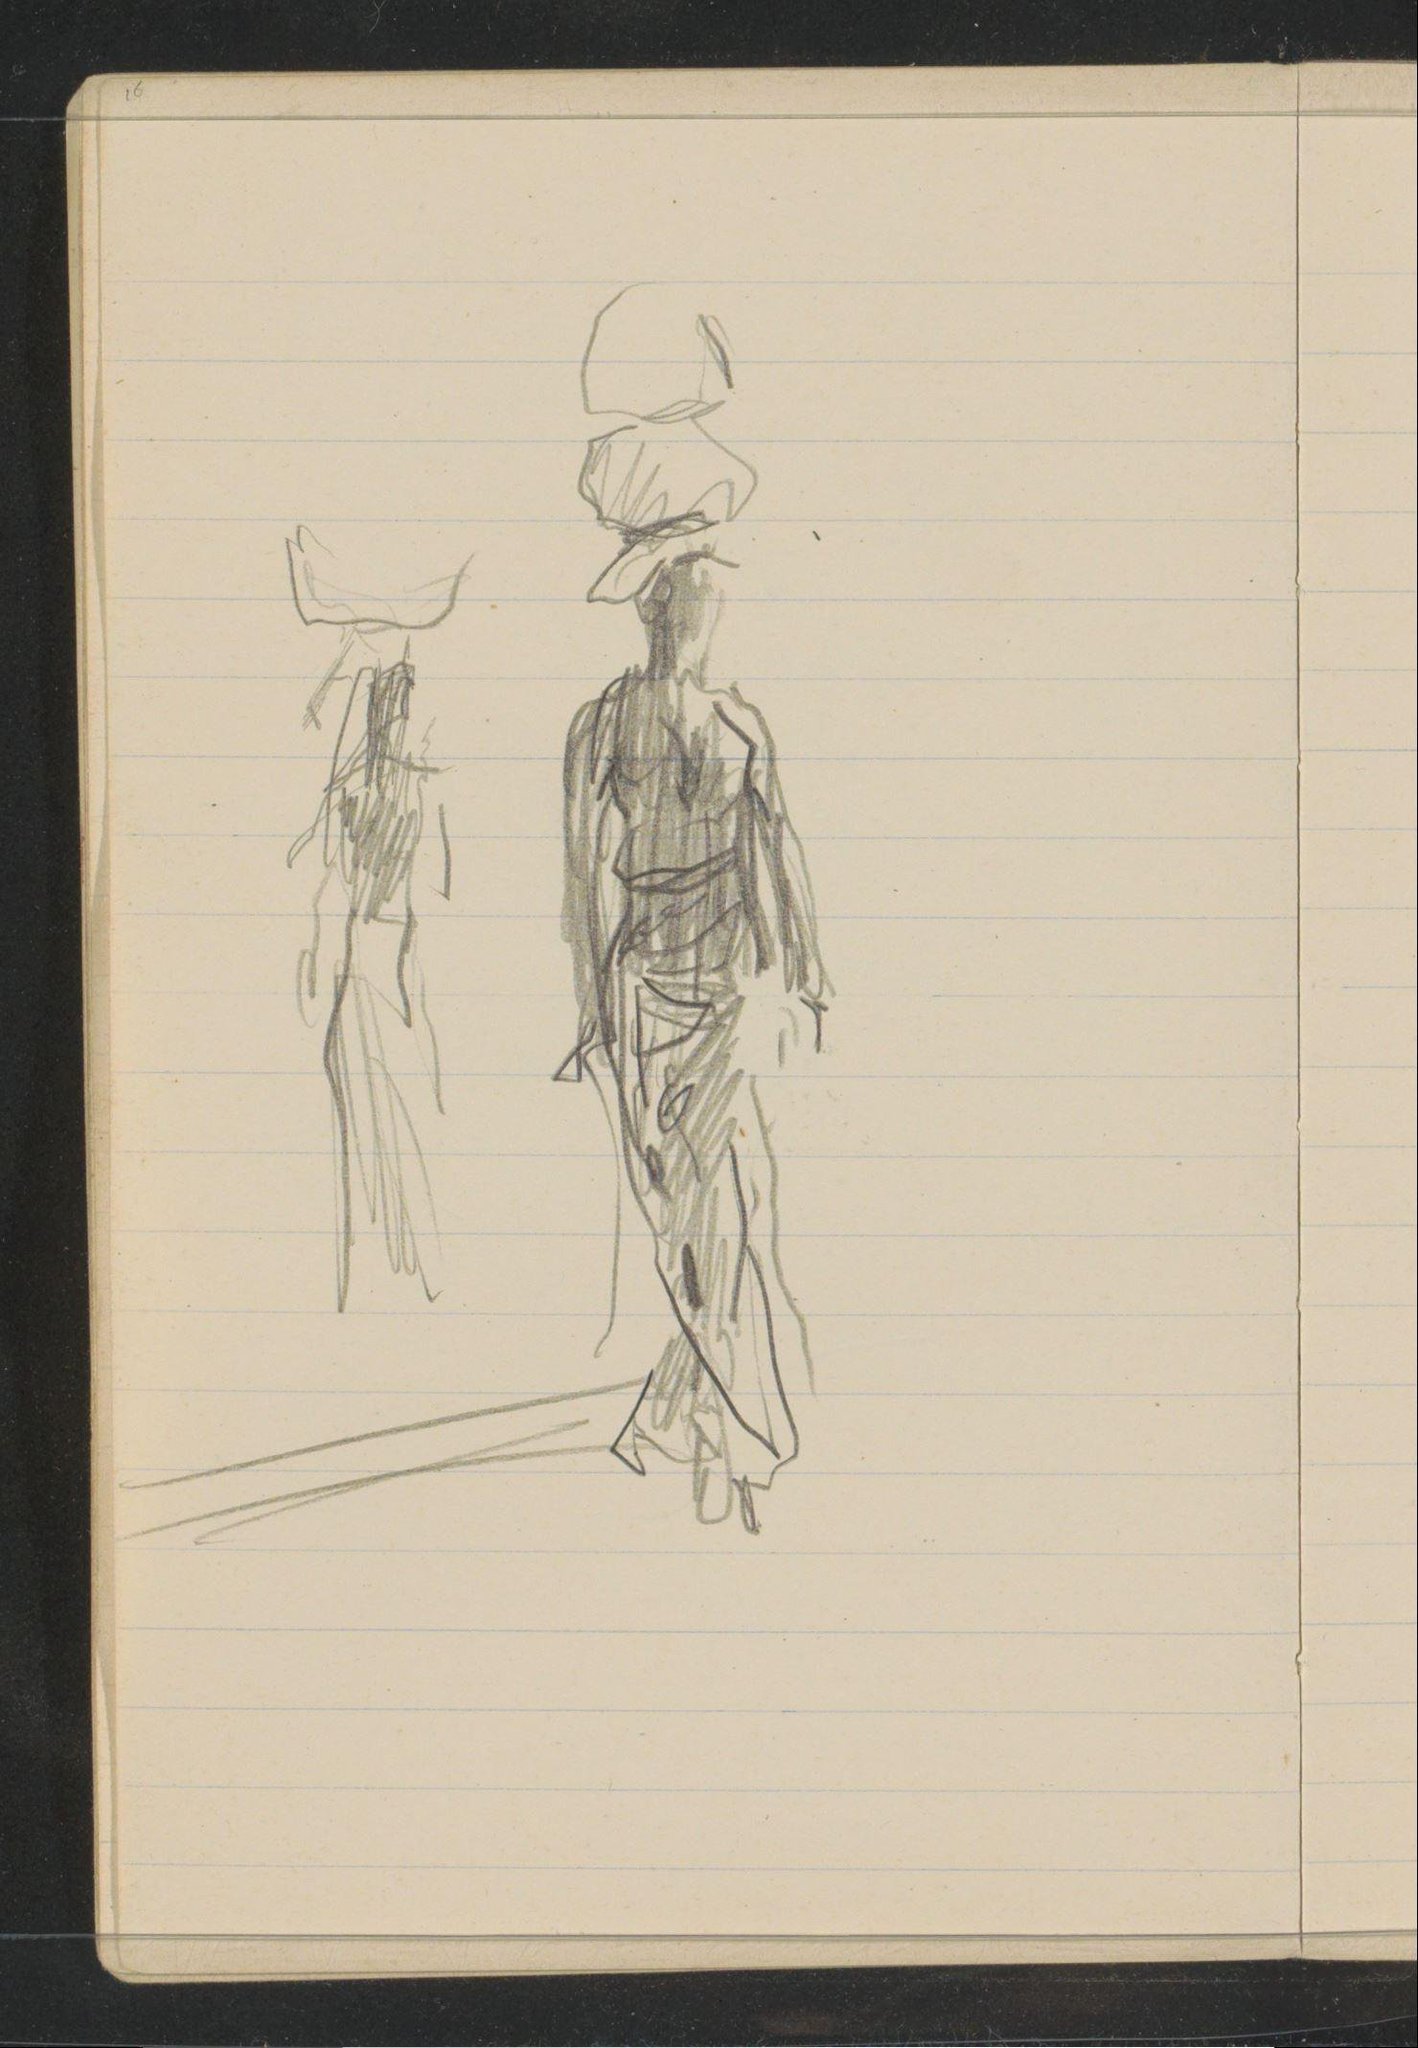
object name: sketchbook leaf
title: Indonesische vrouwen met schalen op het hoofd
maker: marius bauer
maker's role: draughtsman, print maker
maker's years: 1867-1932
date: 1931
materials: pencil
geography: java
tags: asiatic races and peoples, adult woman, carrying something on the head or on the shoulders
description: Pagina 16 uit een schetsboek met 74 bladen.